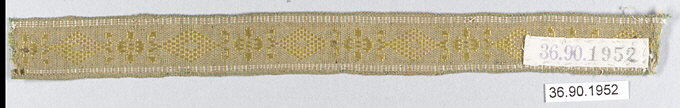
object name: galloon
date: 1801-1900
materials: silk